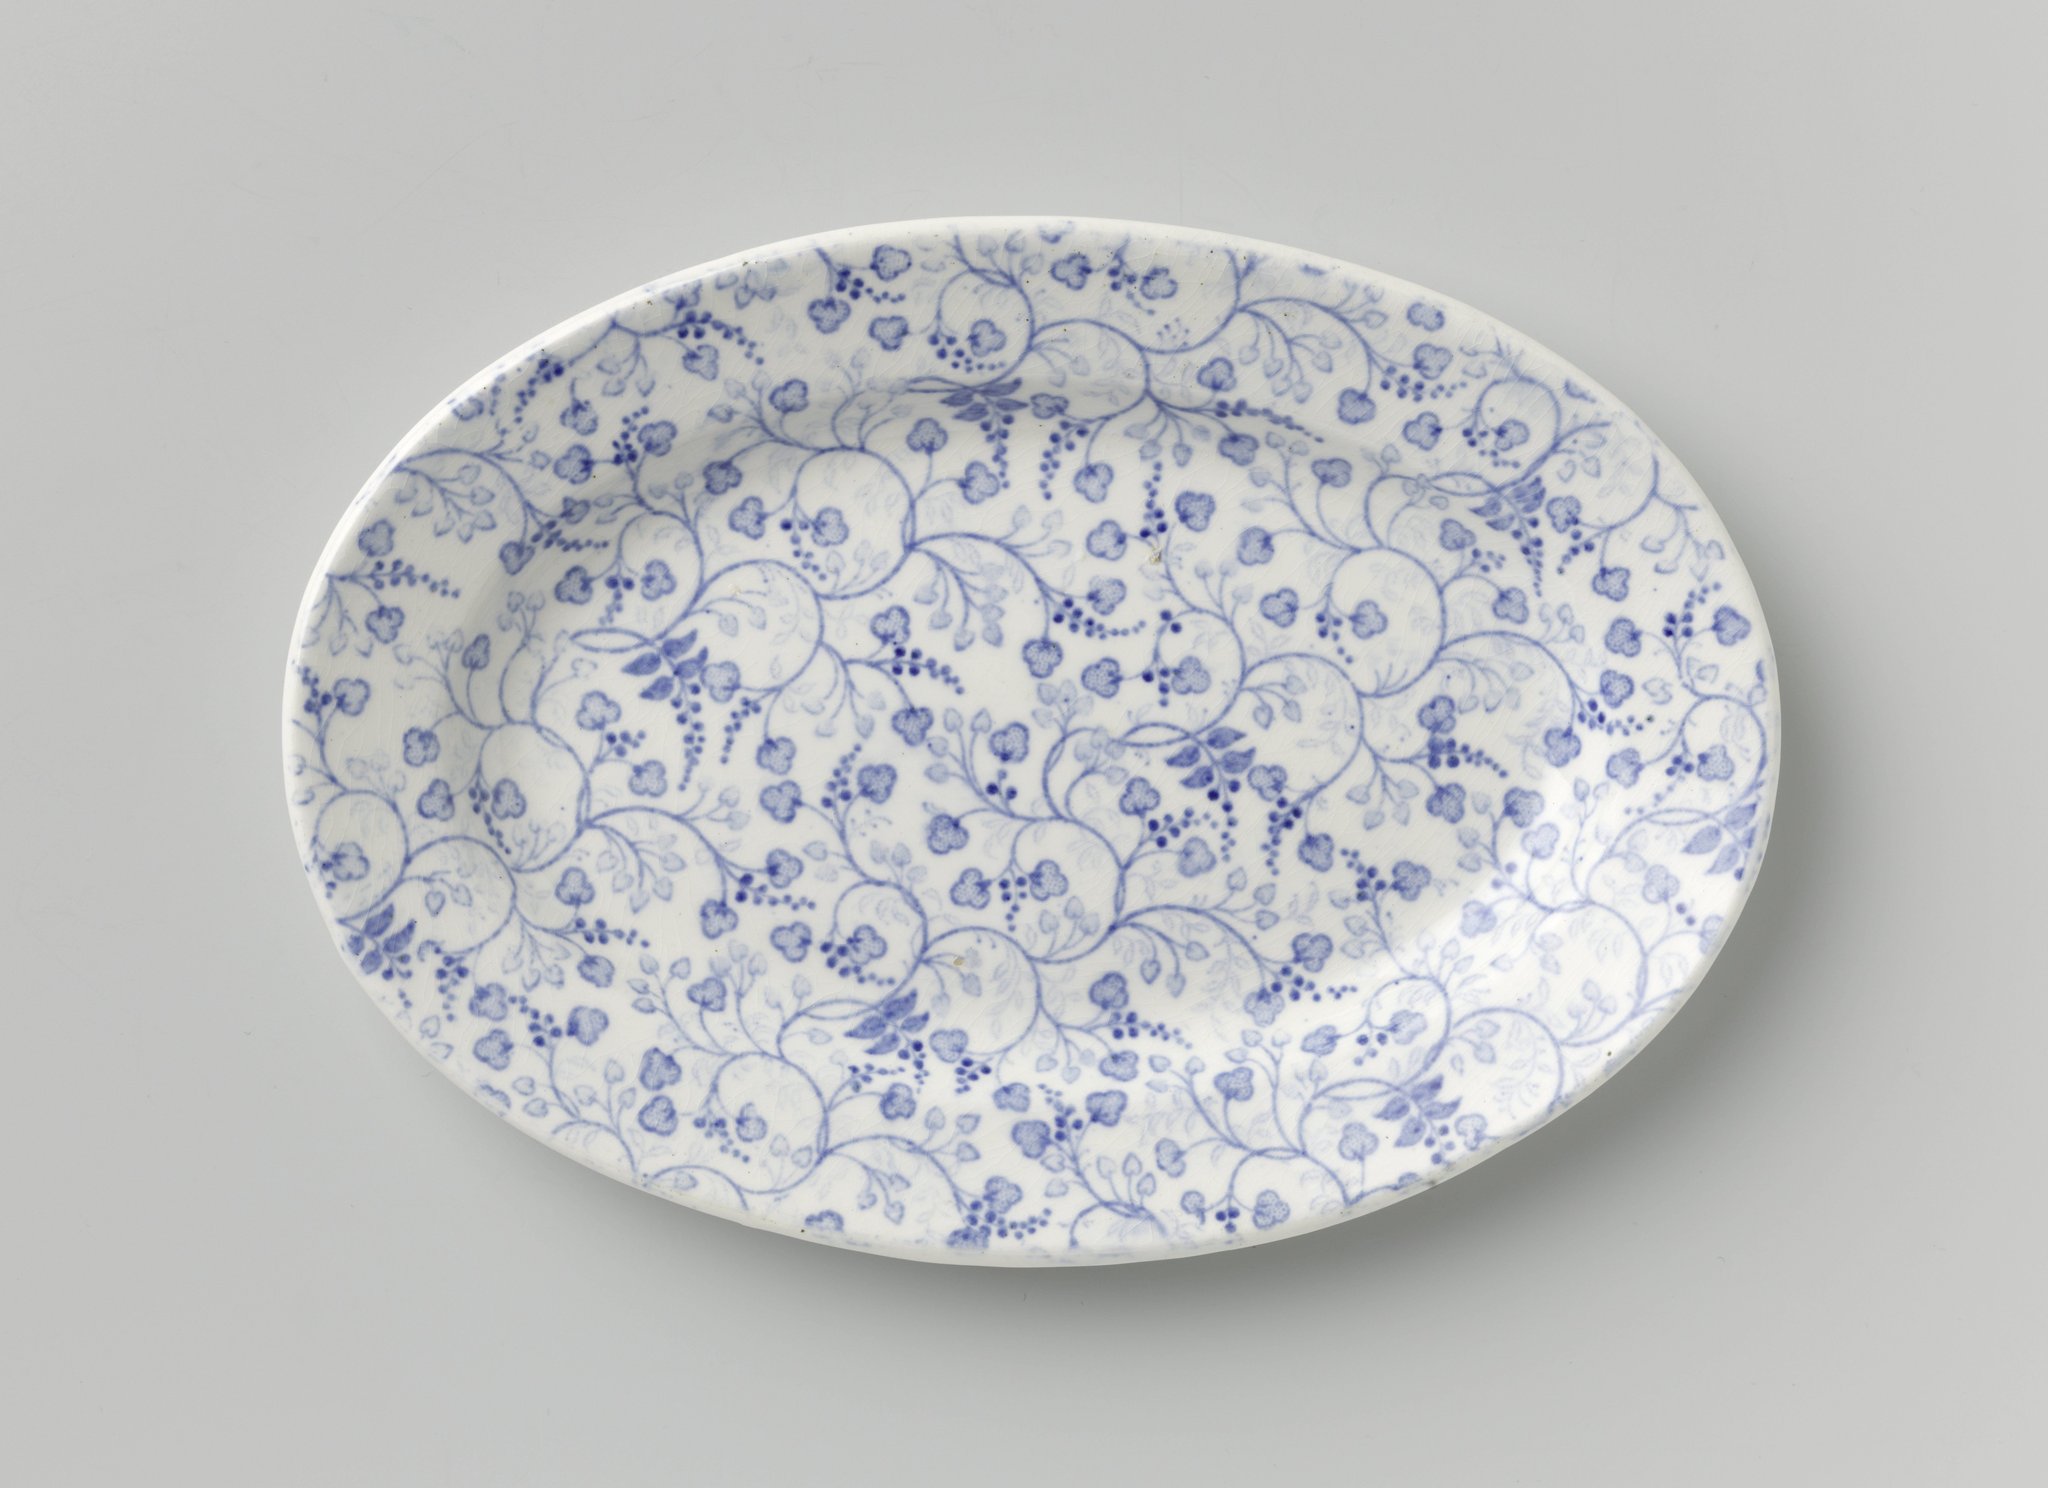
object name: dish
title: Schaal, ovaal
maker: petrus regout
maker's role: plateelbakker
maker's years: 1801-1879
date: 1867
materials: creamware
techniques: transfer decoration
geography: maastricht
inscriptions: mark: ‘PARSEME No 3’, check stamp: ‘PR 17 1’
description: Schaal van aardewerk, ovaal, met blauw doorlopend bloemendecor, behorend tot een kinderservies.